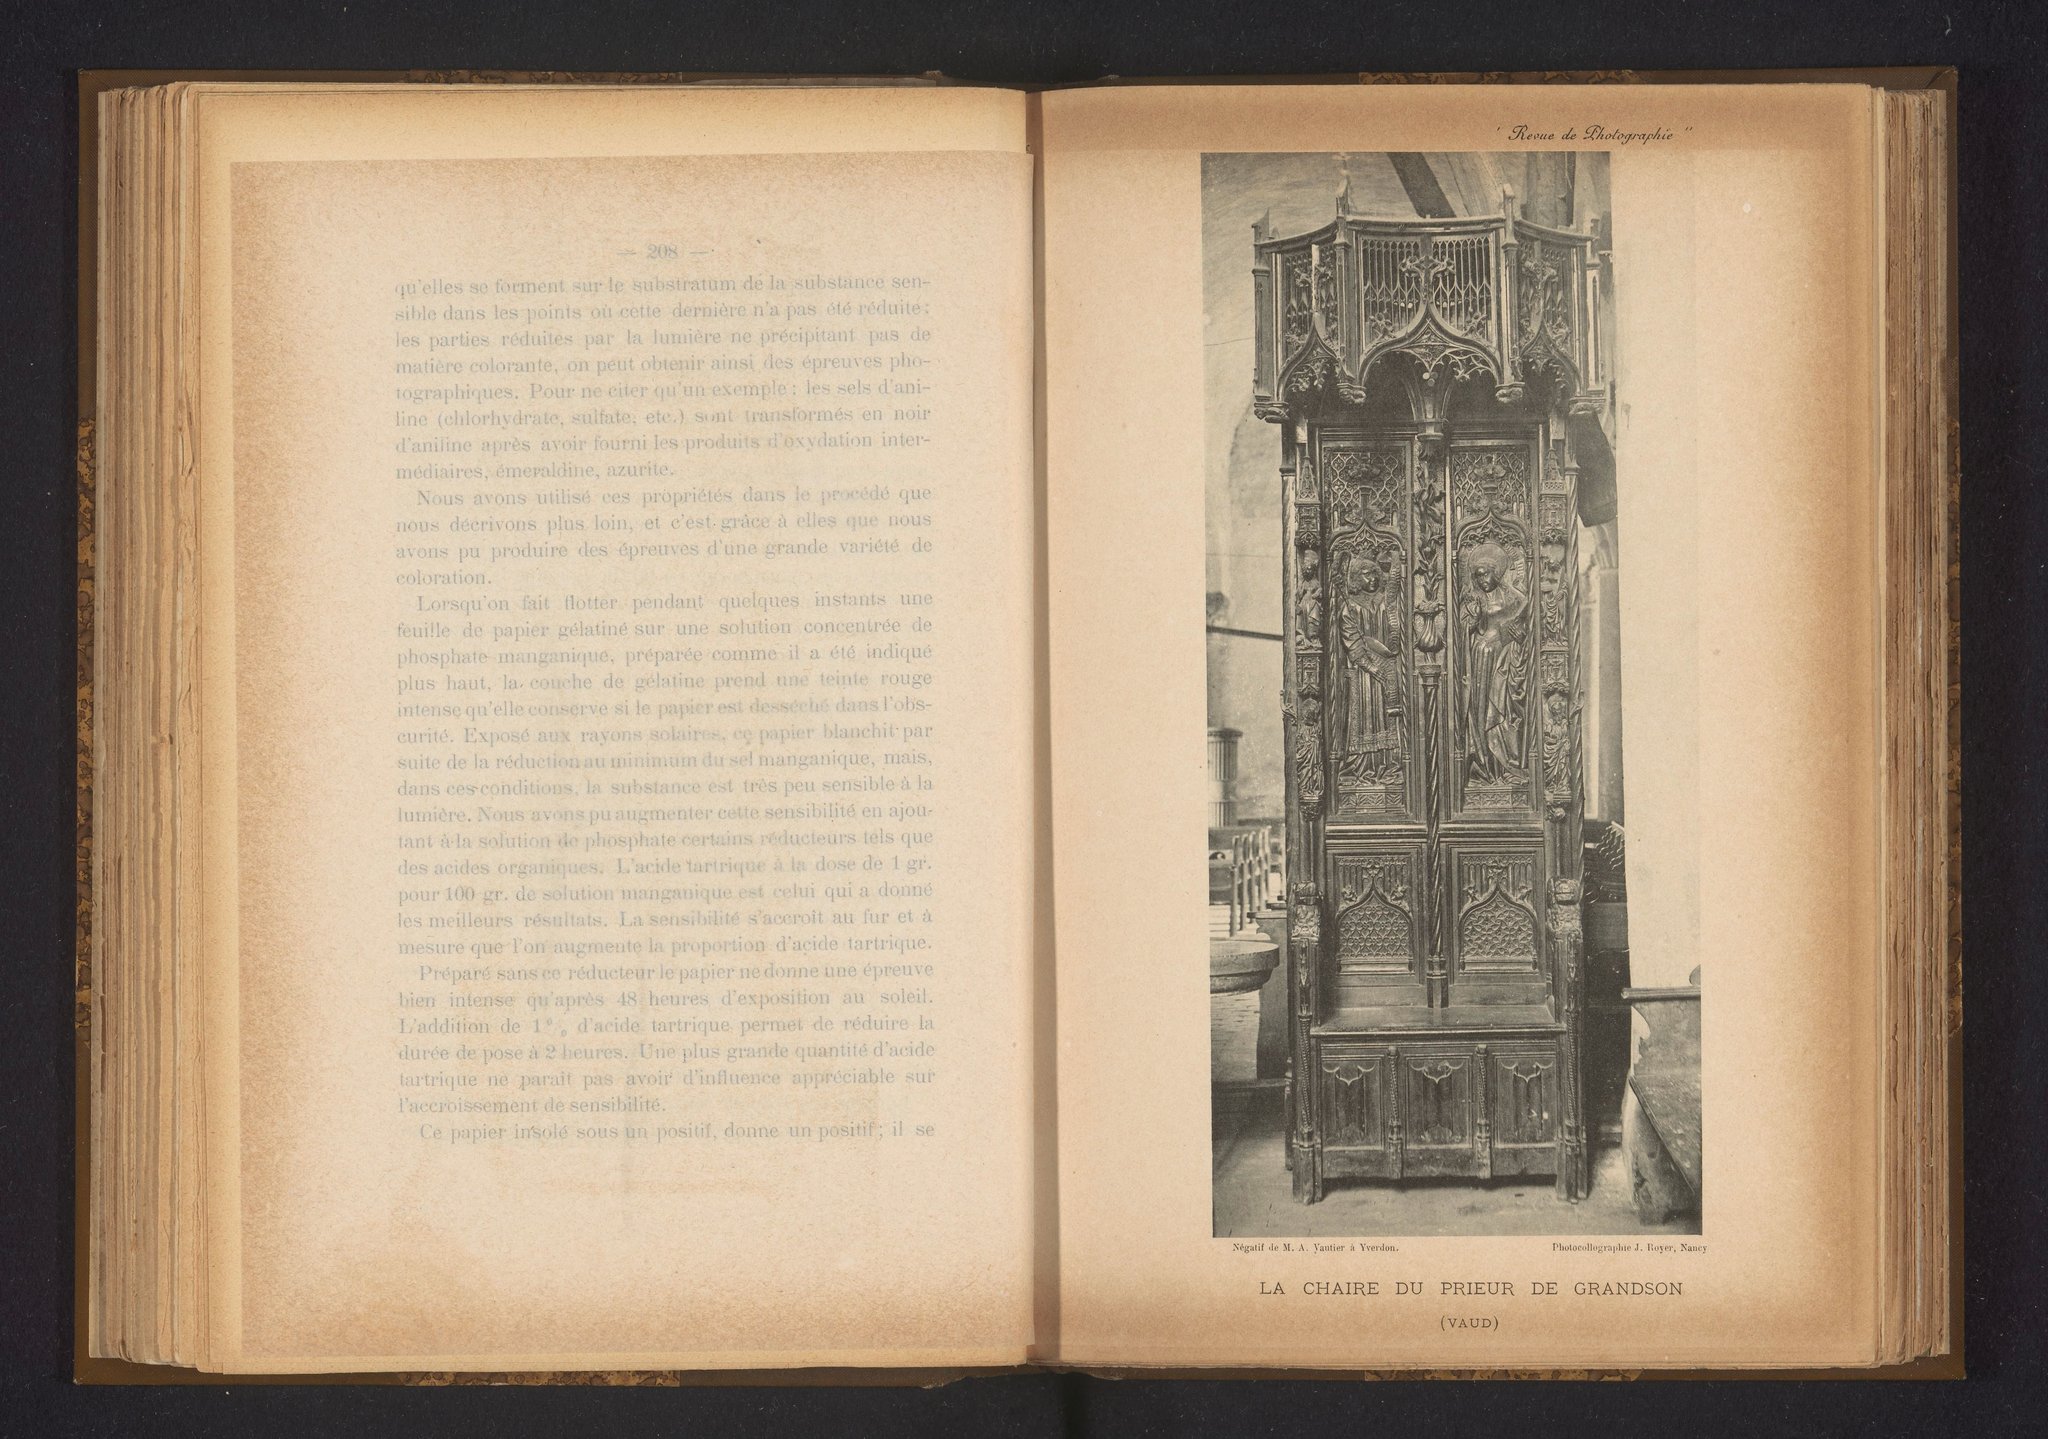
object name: photomechanical print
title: Preekstoel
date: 1887-1892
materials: paper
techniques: photograph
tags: pulpit, ambo, chancel